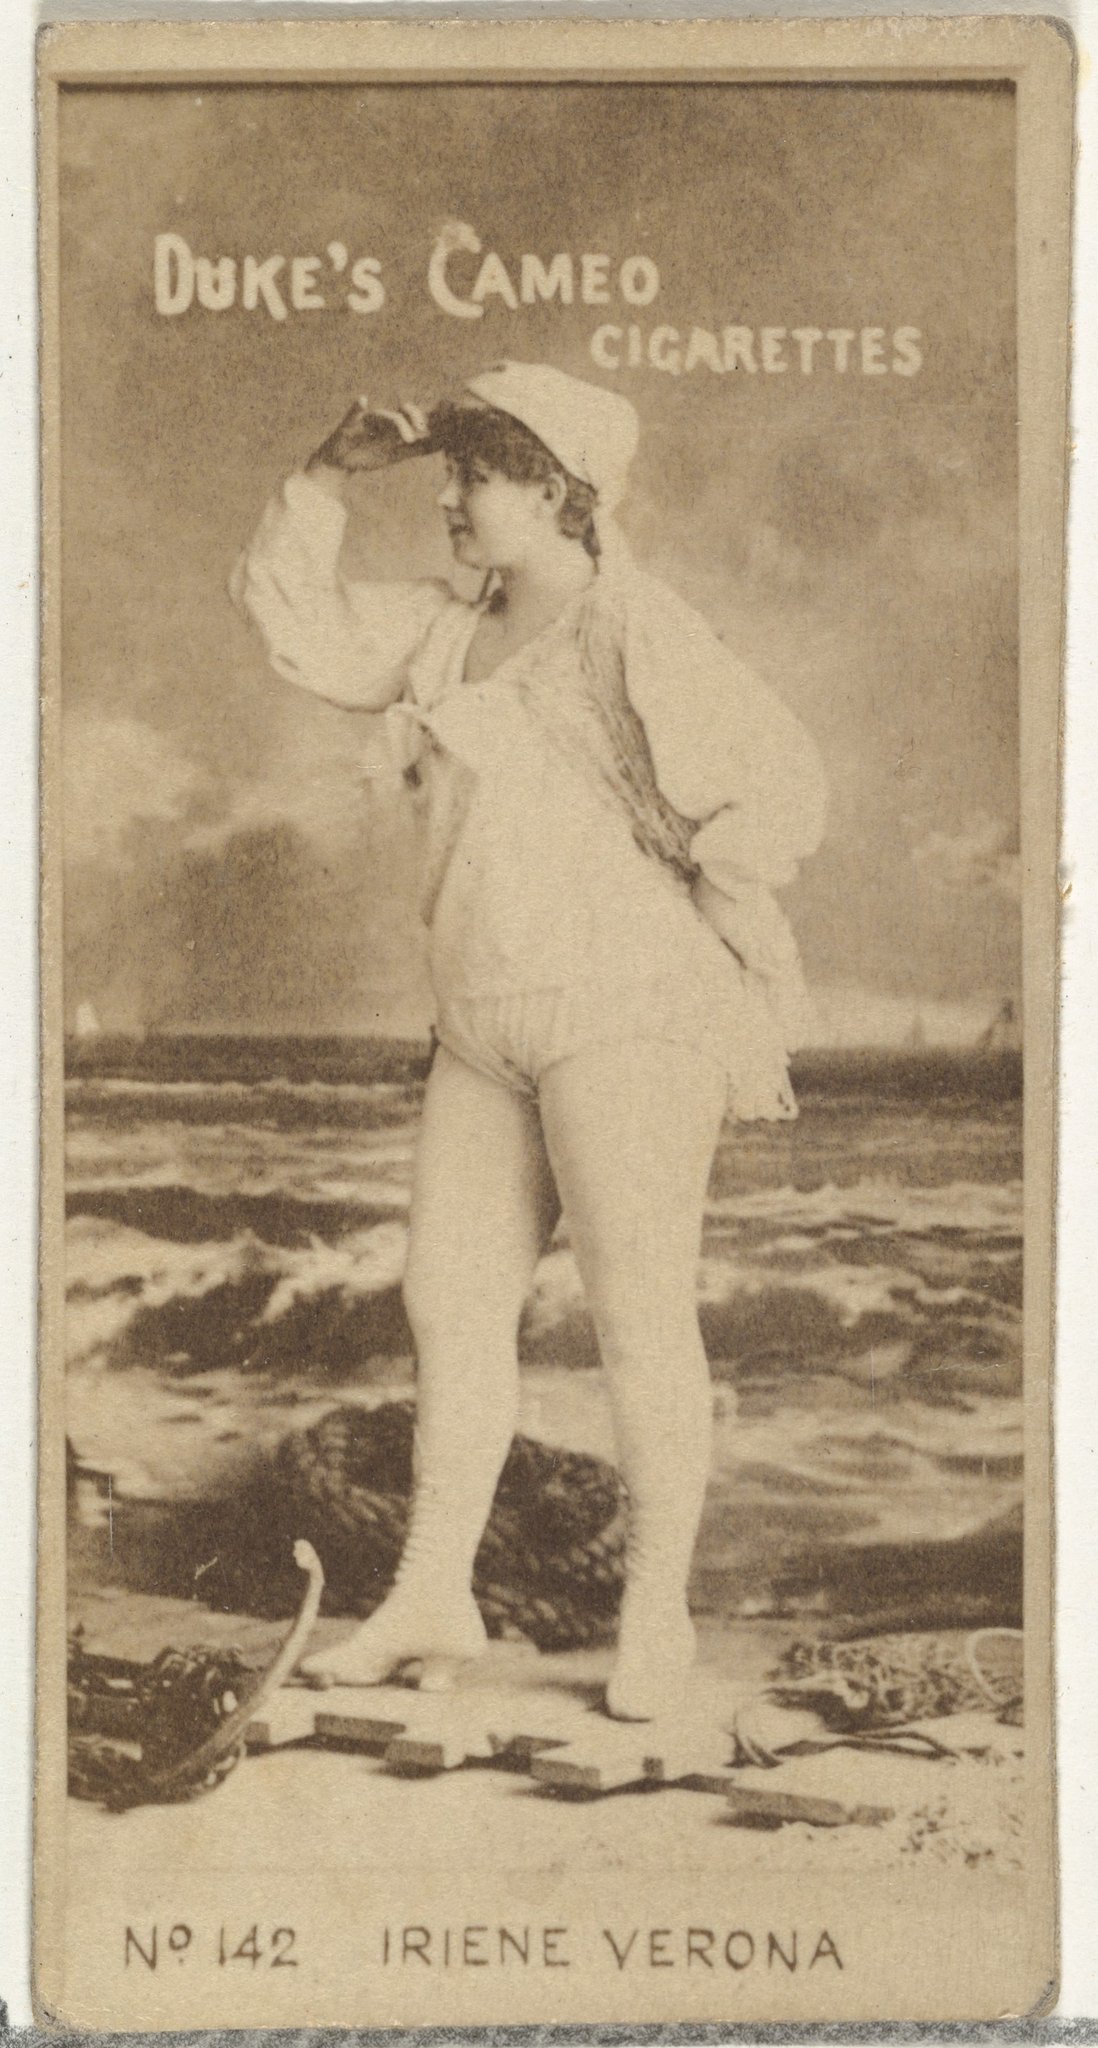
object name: photograph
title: Card Number 142, Irene Verona, from the Actors and Actresses series (N145-4) issued by Duke Sons & Co. to promote Cameo Cigarettes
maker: w. duke, sons & co.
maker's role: publisher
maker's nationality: american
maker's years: 1870-1920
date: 1880-1889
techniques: albumen silver print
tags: women,actresses